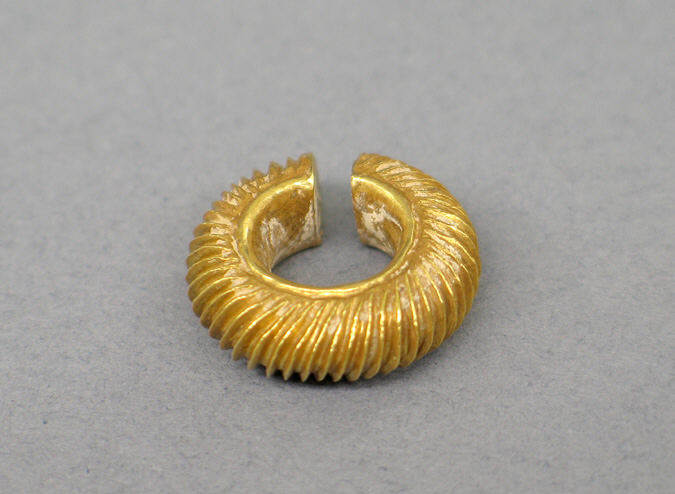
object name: ear clip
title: Pair of Ear Clips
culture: indonesian, javanese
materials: gold